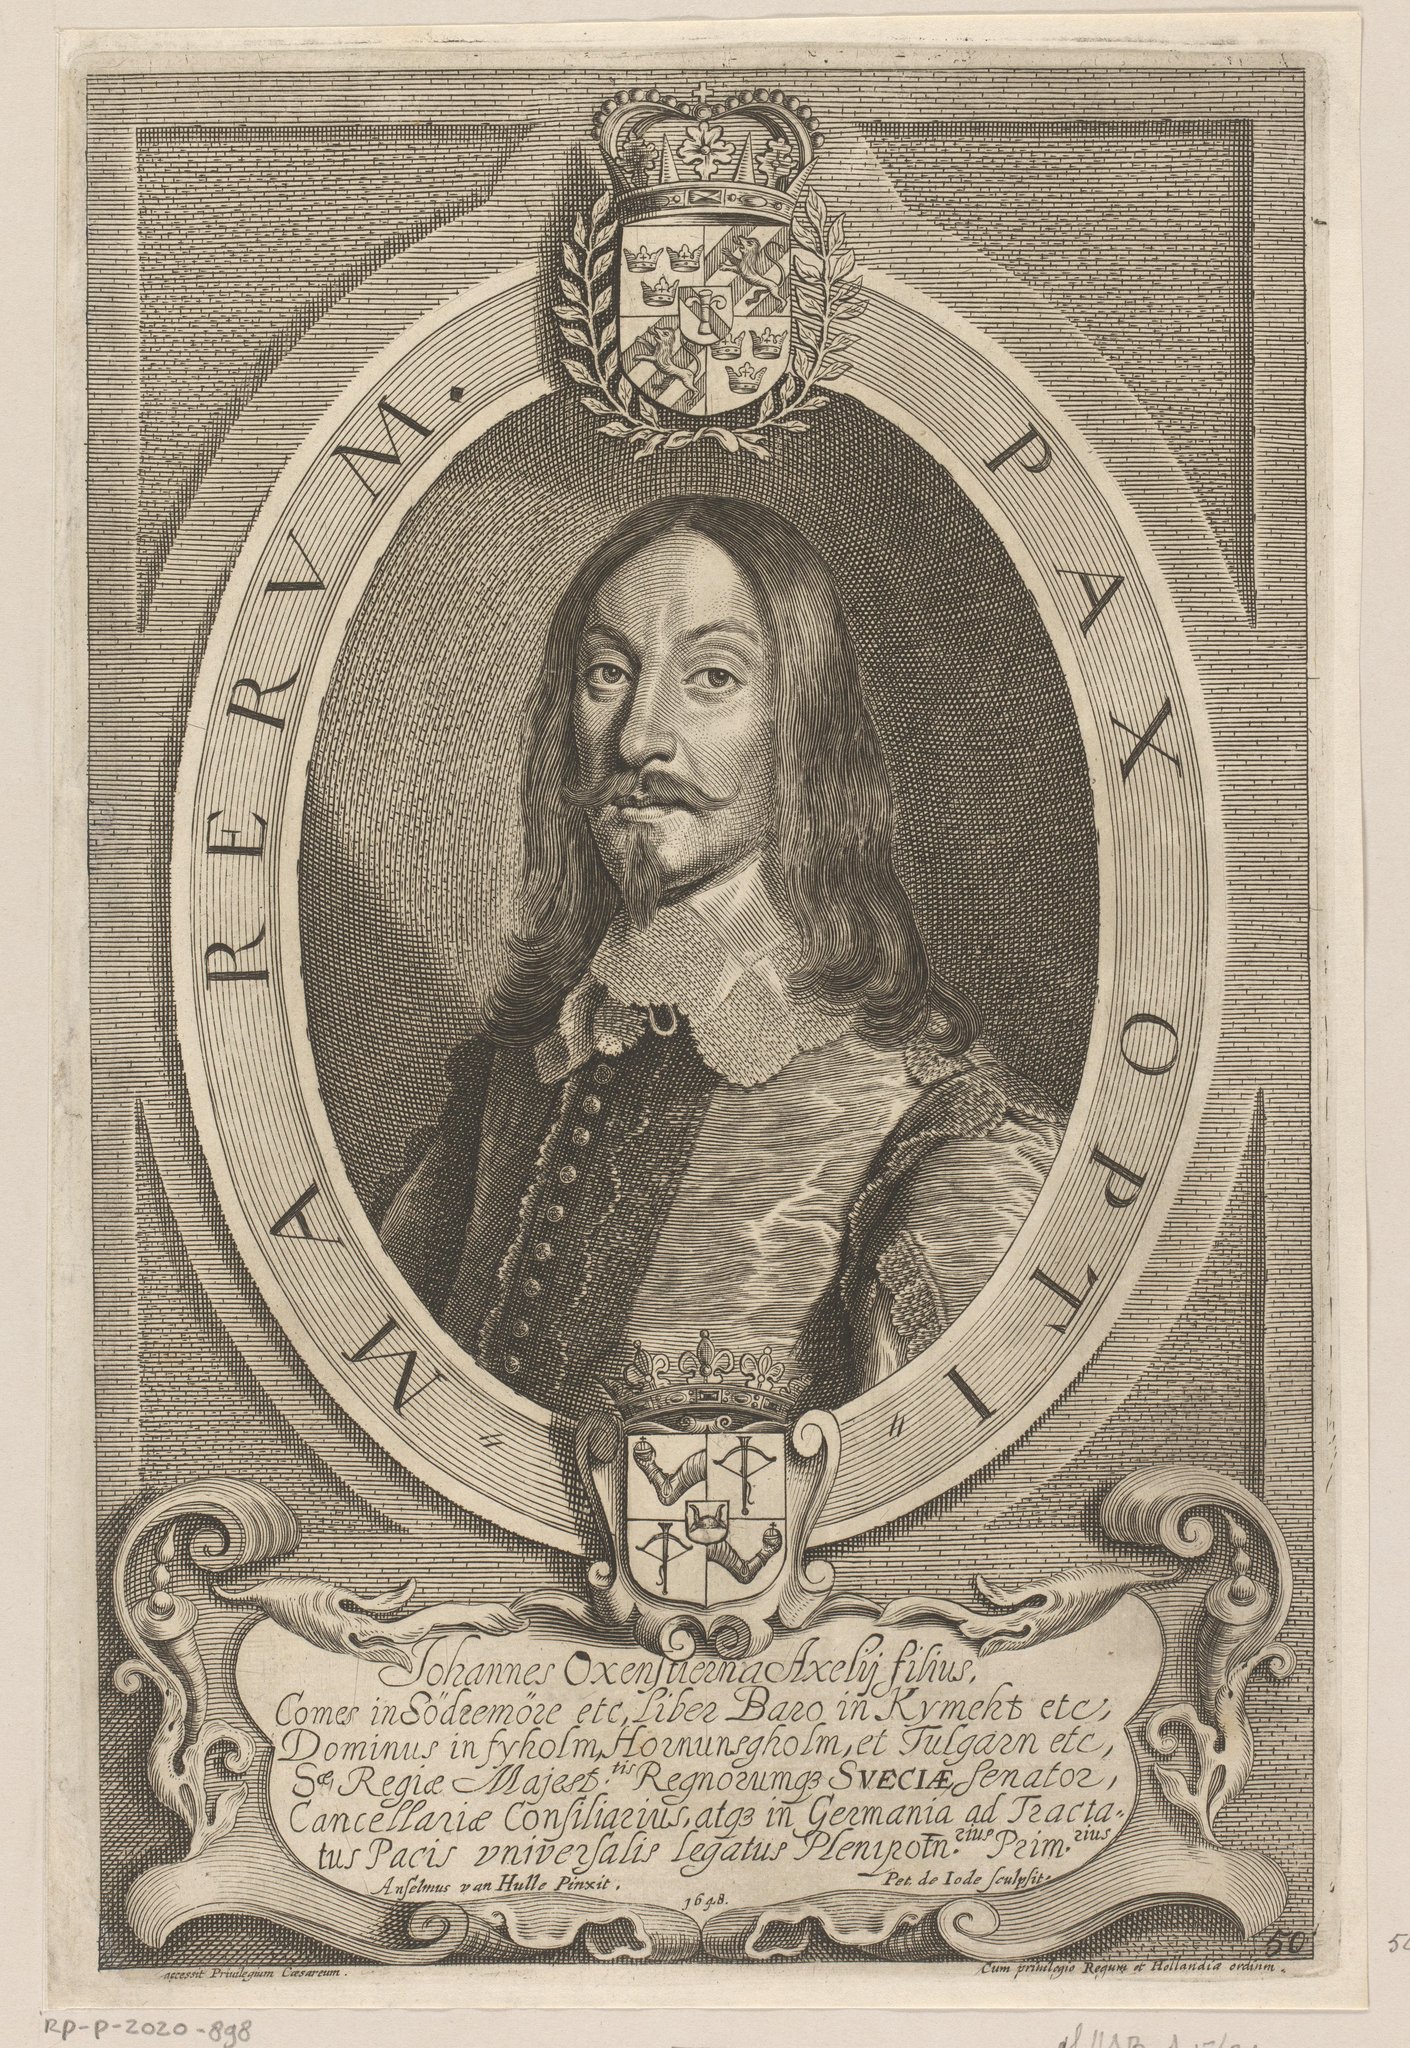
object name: print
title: Portret van Johan Oxenstierna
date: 1697-1717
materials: paper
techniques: engraving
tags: historical persons, diplomacy, diplomat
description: Prent is gebruikt in verschillende series. De huidige staat is gebruikt in de hieronder vermelde serie en uitgaven (6), (7) en (8). (1)'Icones legatorum (...)', uitgegeven door Daniel Middeler in 1648 in Antwerpen. (2)‘Legati Celeberrimi’, uitgegeven door Daniel Middeler in 1648 in Antwerpen. (3)‘Legati Celeberrimi’, waarschijnlijk uitgegeven in 1651, maar opnieuw met de vermelding door Daniel Middeler in 1648 in Antwerpen. (4)‘Legati Celeberrimi', waarschijnlijk uitgegeven in 1658, maar opnieuw met de vermelding door Daniel Middeler in 1648 in Antwerpen. (5) 'Pacificatores orbis Christiani, sive icones principum, ducum et legatorum, qui Monasterii atque Osnabrugae (...)', uitgegeven door Pieter van der Slaart in 1696 in Rotterdam. (6) 'Pacificatores orbis Christiani, sive icones principum, ducum et legatorum, qui Monasterii atque Osnabrugae (...)', uitgegeven door Pieter van der Slaart in 1697 in Rotterdam. (7) 'Pacificatores orbis Christiani, sive icones principum, ducum et legatorum, qui Monasterii atque Osnabrugae (...)', waarschijnlijk uitgegeven circa 1713, maar opnieuw met vermelding van Pieter van der Slaart in 1697 in Rotterdam. De platen in deze uitgave zijn voor het eerst genummerd. (8) 'Les hommes illustres qui ont vécu dans le XXIIe siècle (...)', uitgegeven door David Mortier in 1717 in Rotterdam. Zie documentatie. Mogelijk zijn er nog meerdere uitgaven en staten van deze prent.